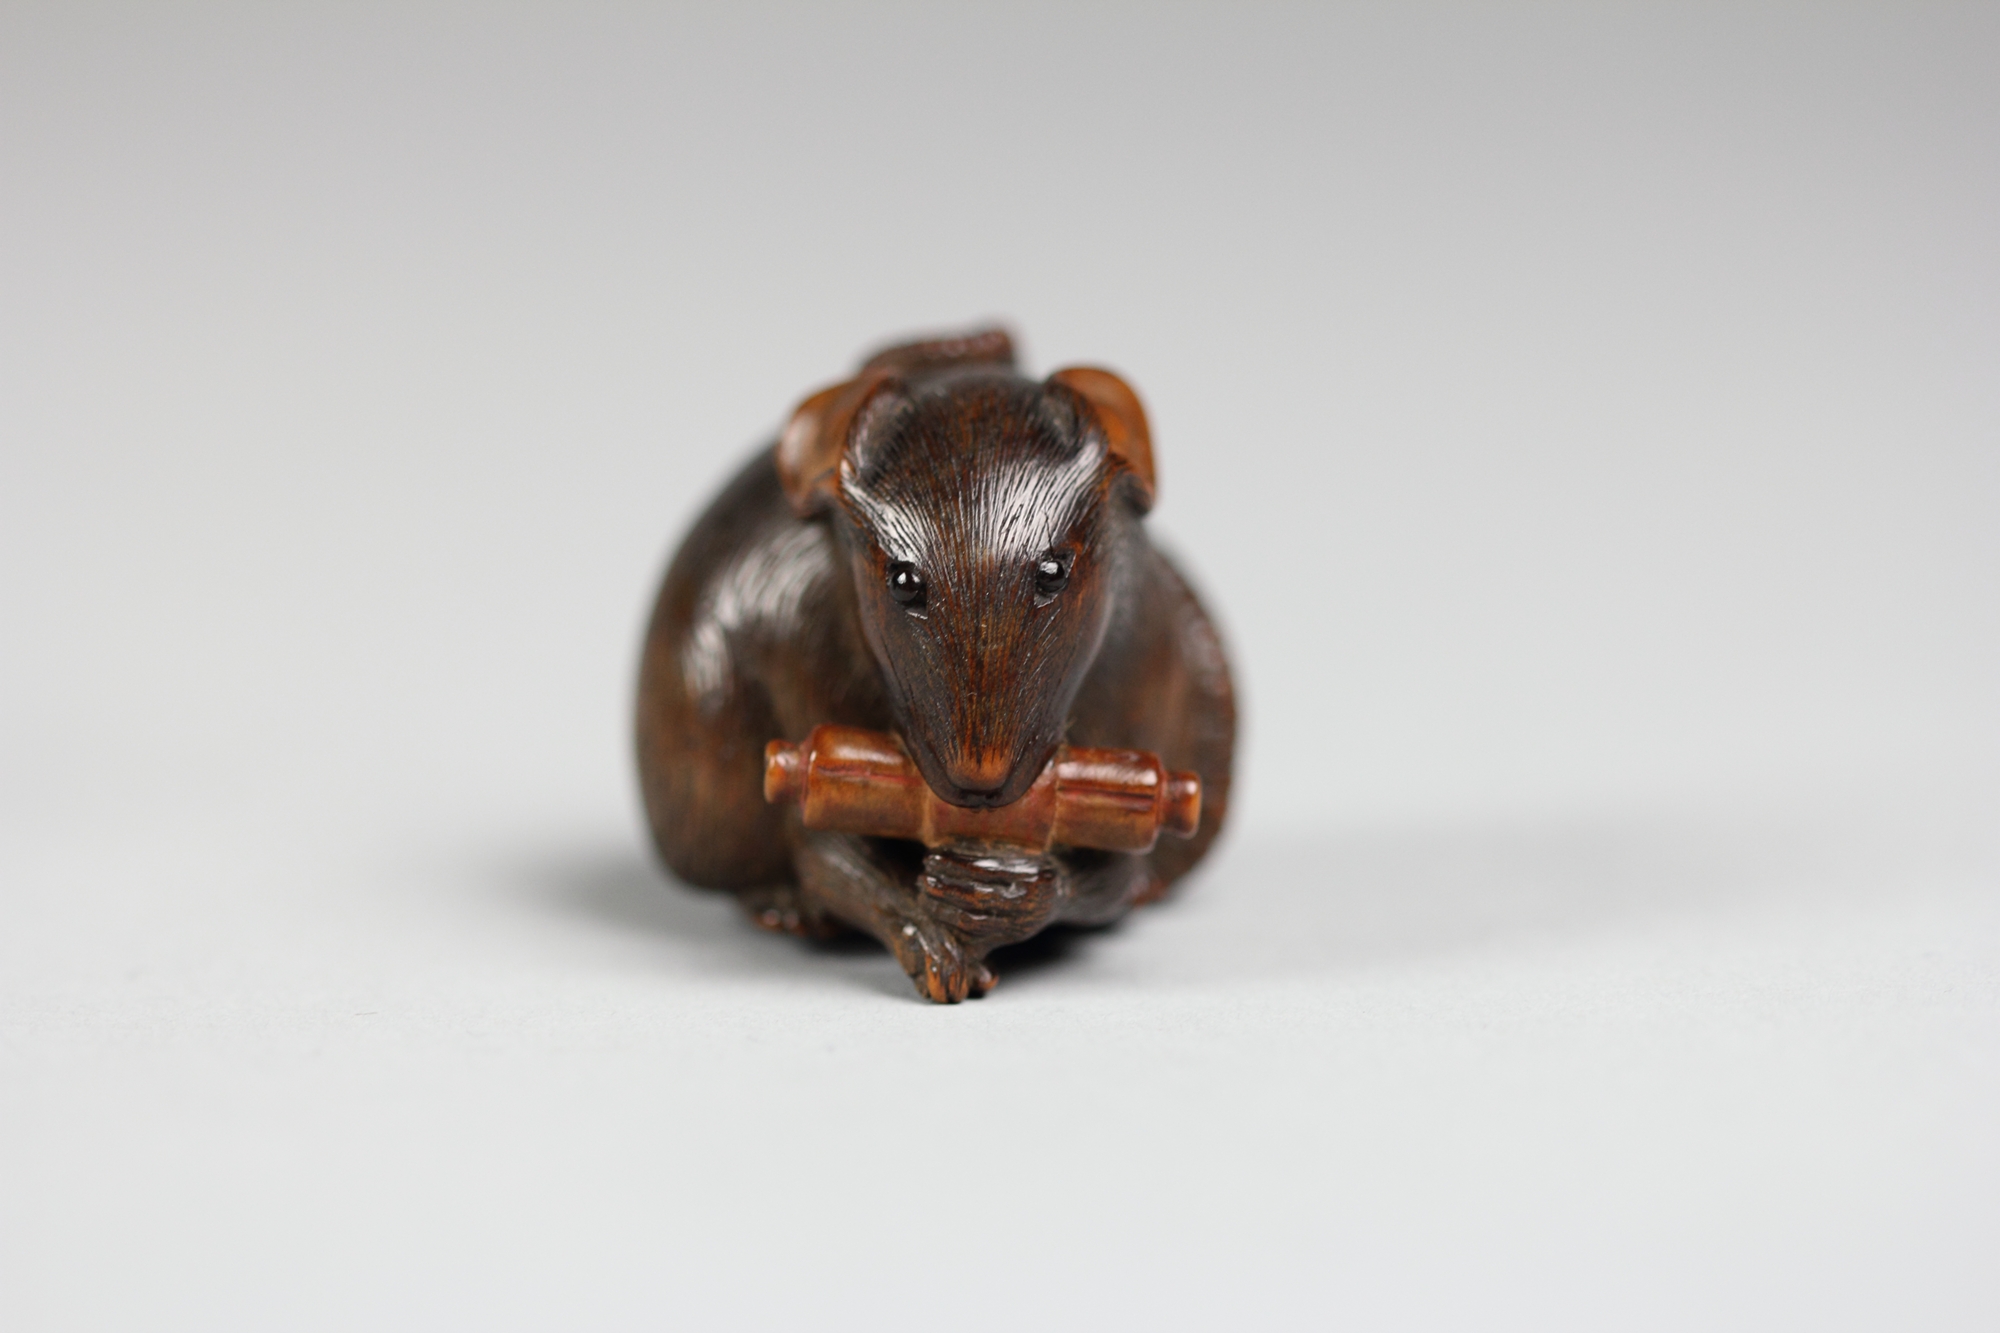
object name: netsuke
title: Netsuke of Mouse with Scroll in Mouth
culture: japanese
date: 1801-1900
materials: wood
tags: mice